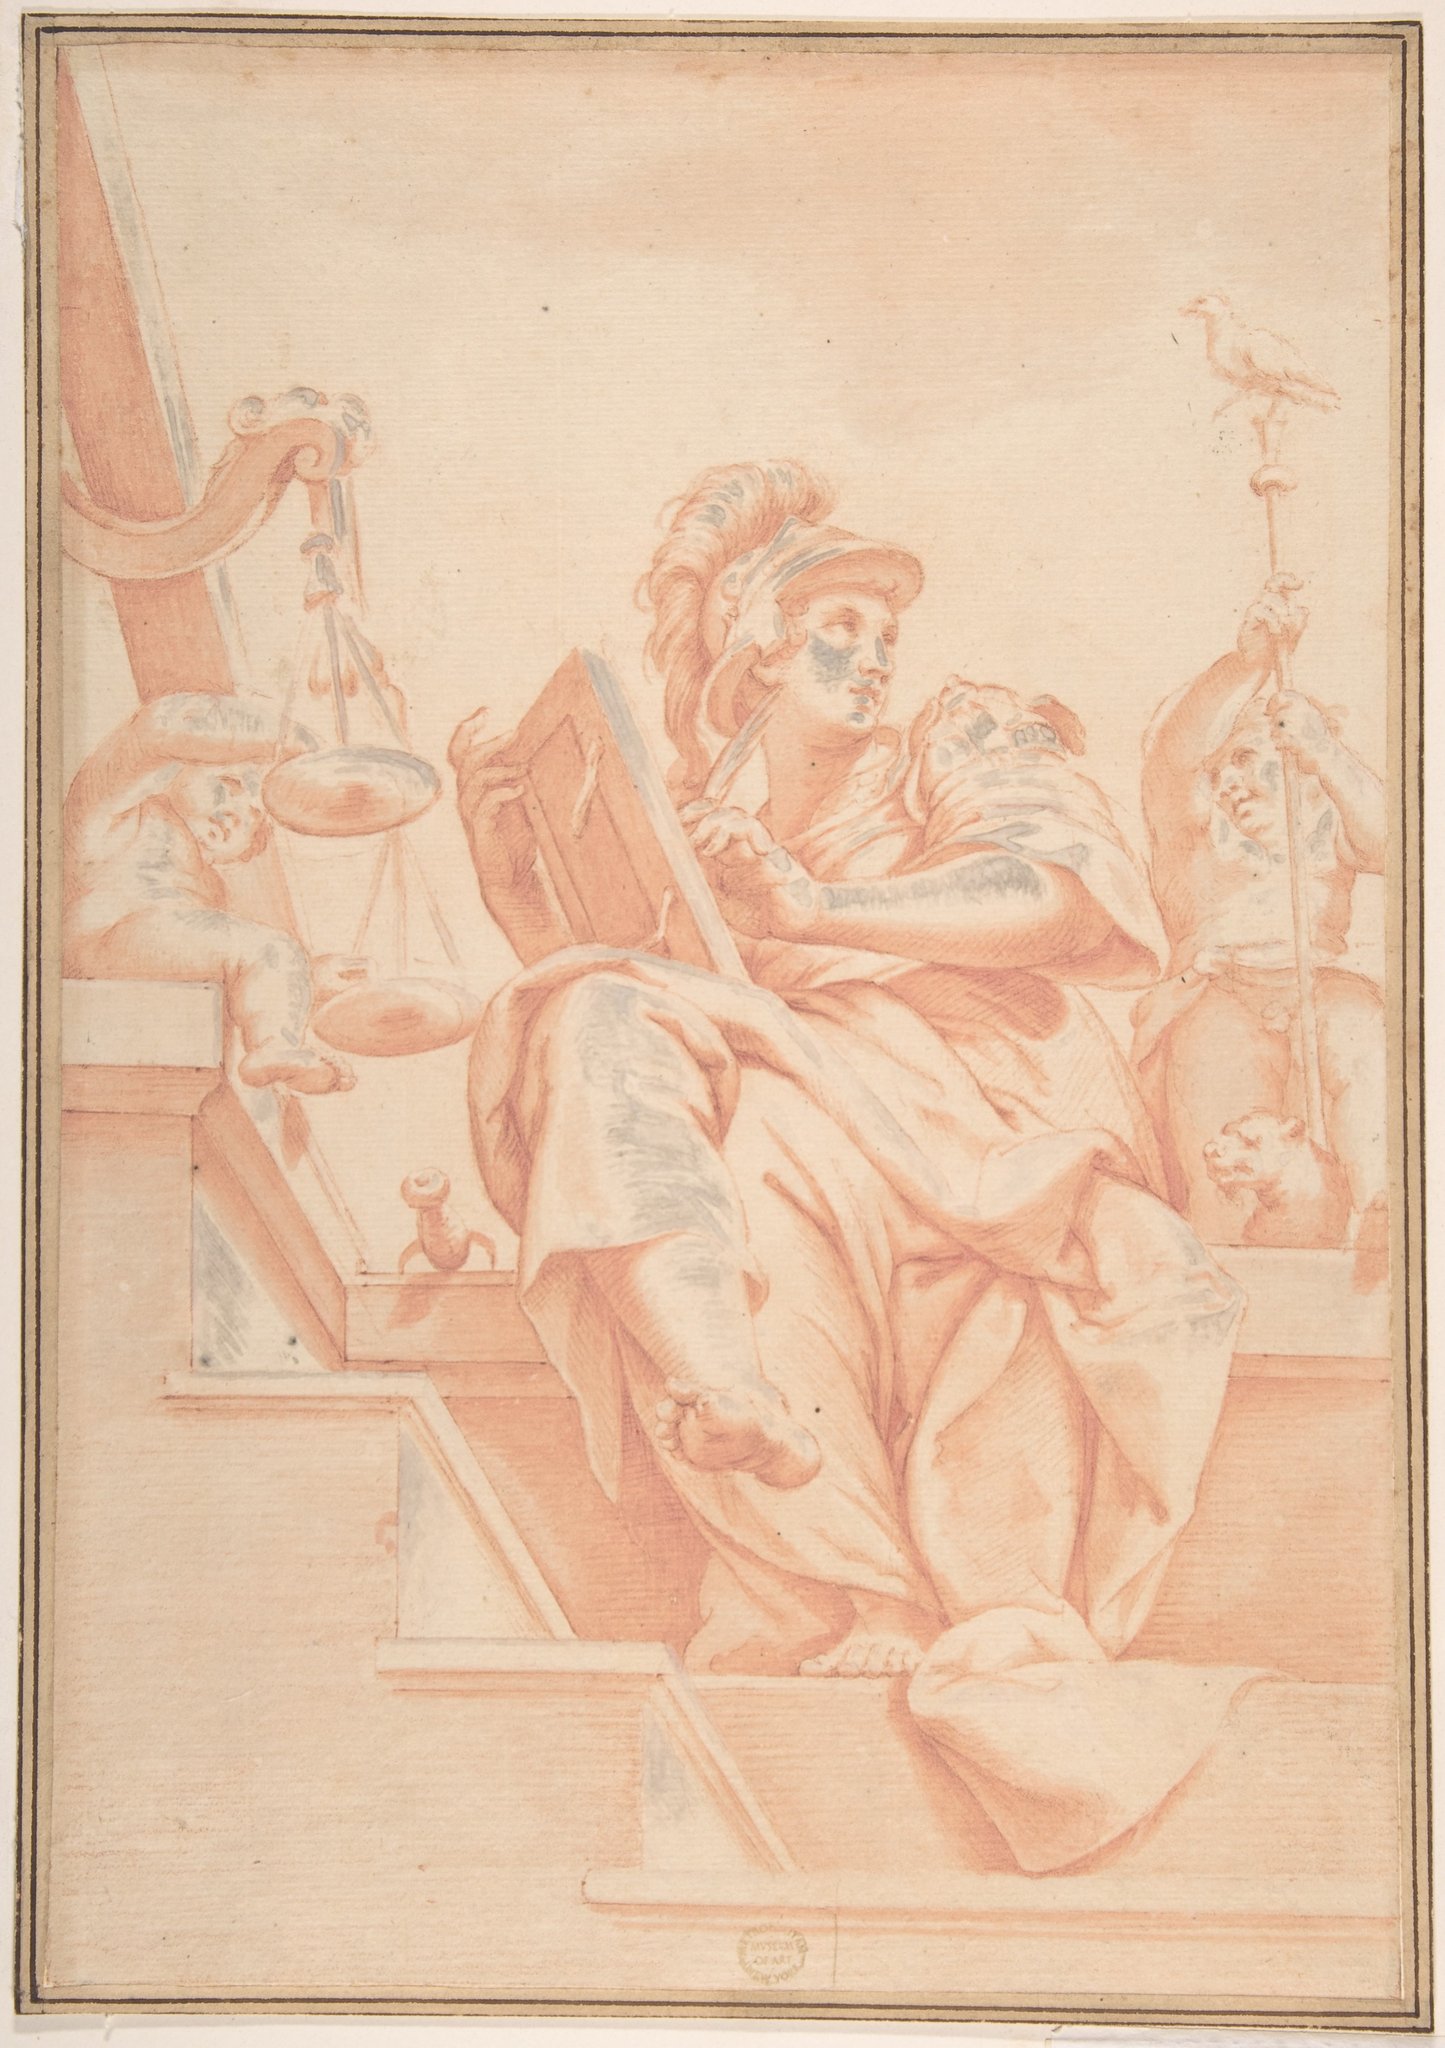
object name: drawing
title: Allegory of Justice with Two Putti (after Lorenzo Sabatini's Fresco in Palazzo Vecchio, Florence)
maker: anonymous, italian, 17th century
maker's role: artist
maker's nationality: italian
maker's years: 1600-1700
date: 1501-1600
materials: chalk, gouache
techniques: brush, highlighting, wash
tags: birds,women,putti